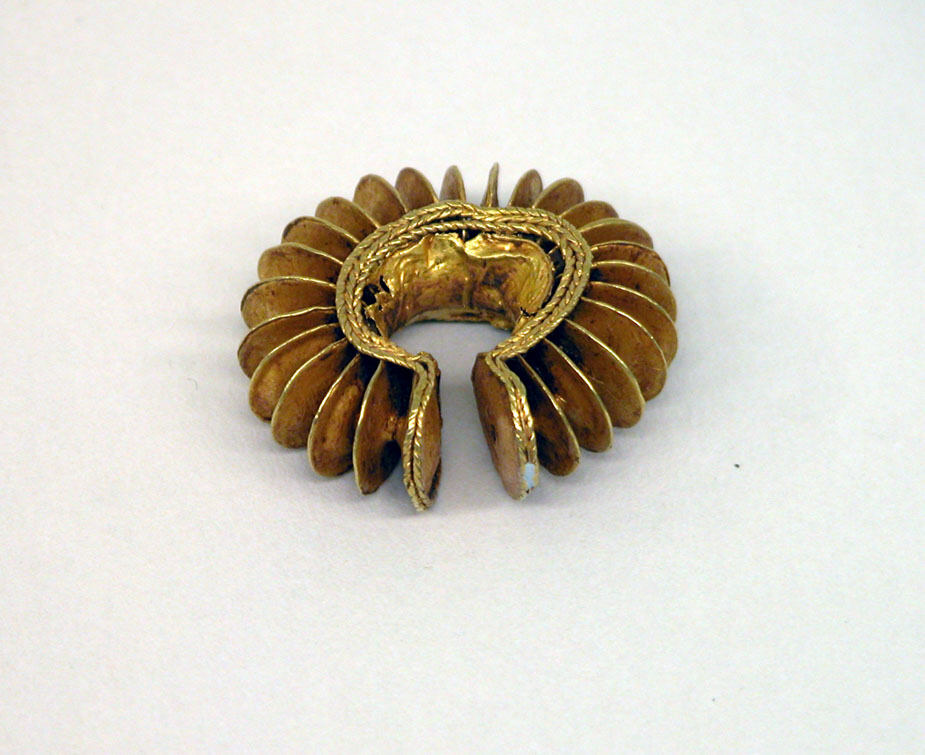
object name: ear clip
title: Pair of Ear Clips Composed of Fused Discs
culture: indonesian, javanese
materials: gold